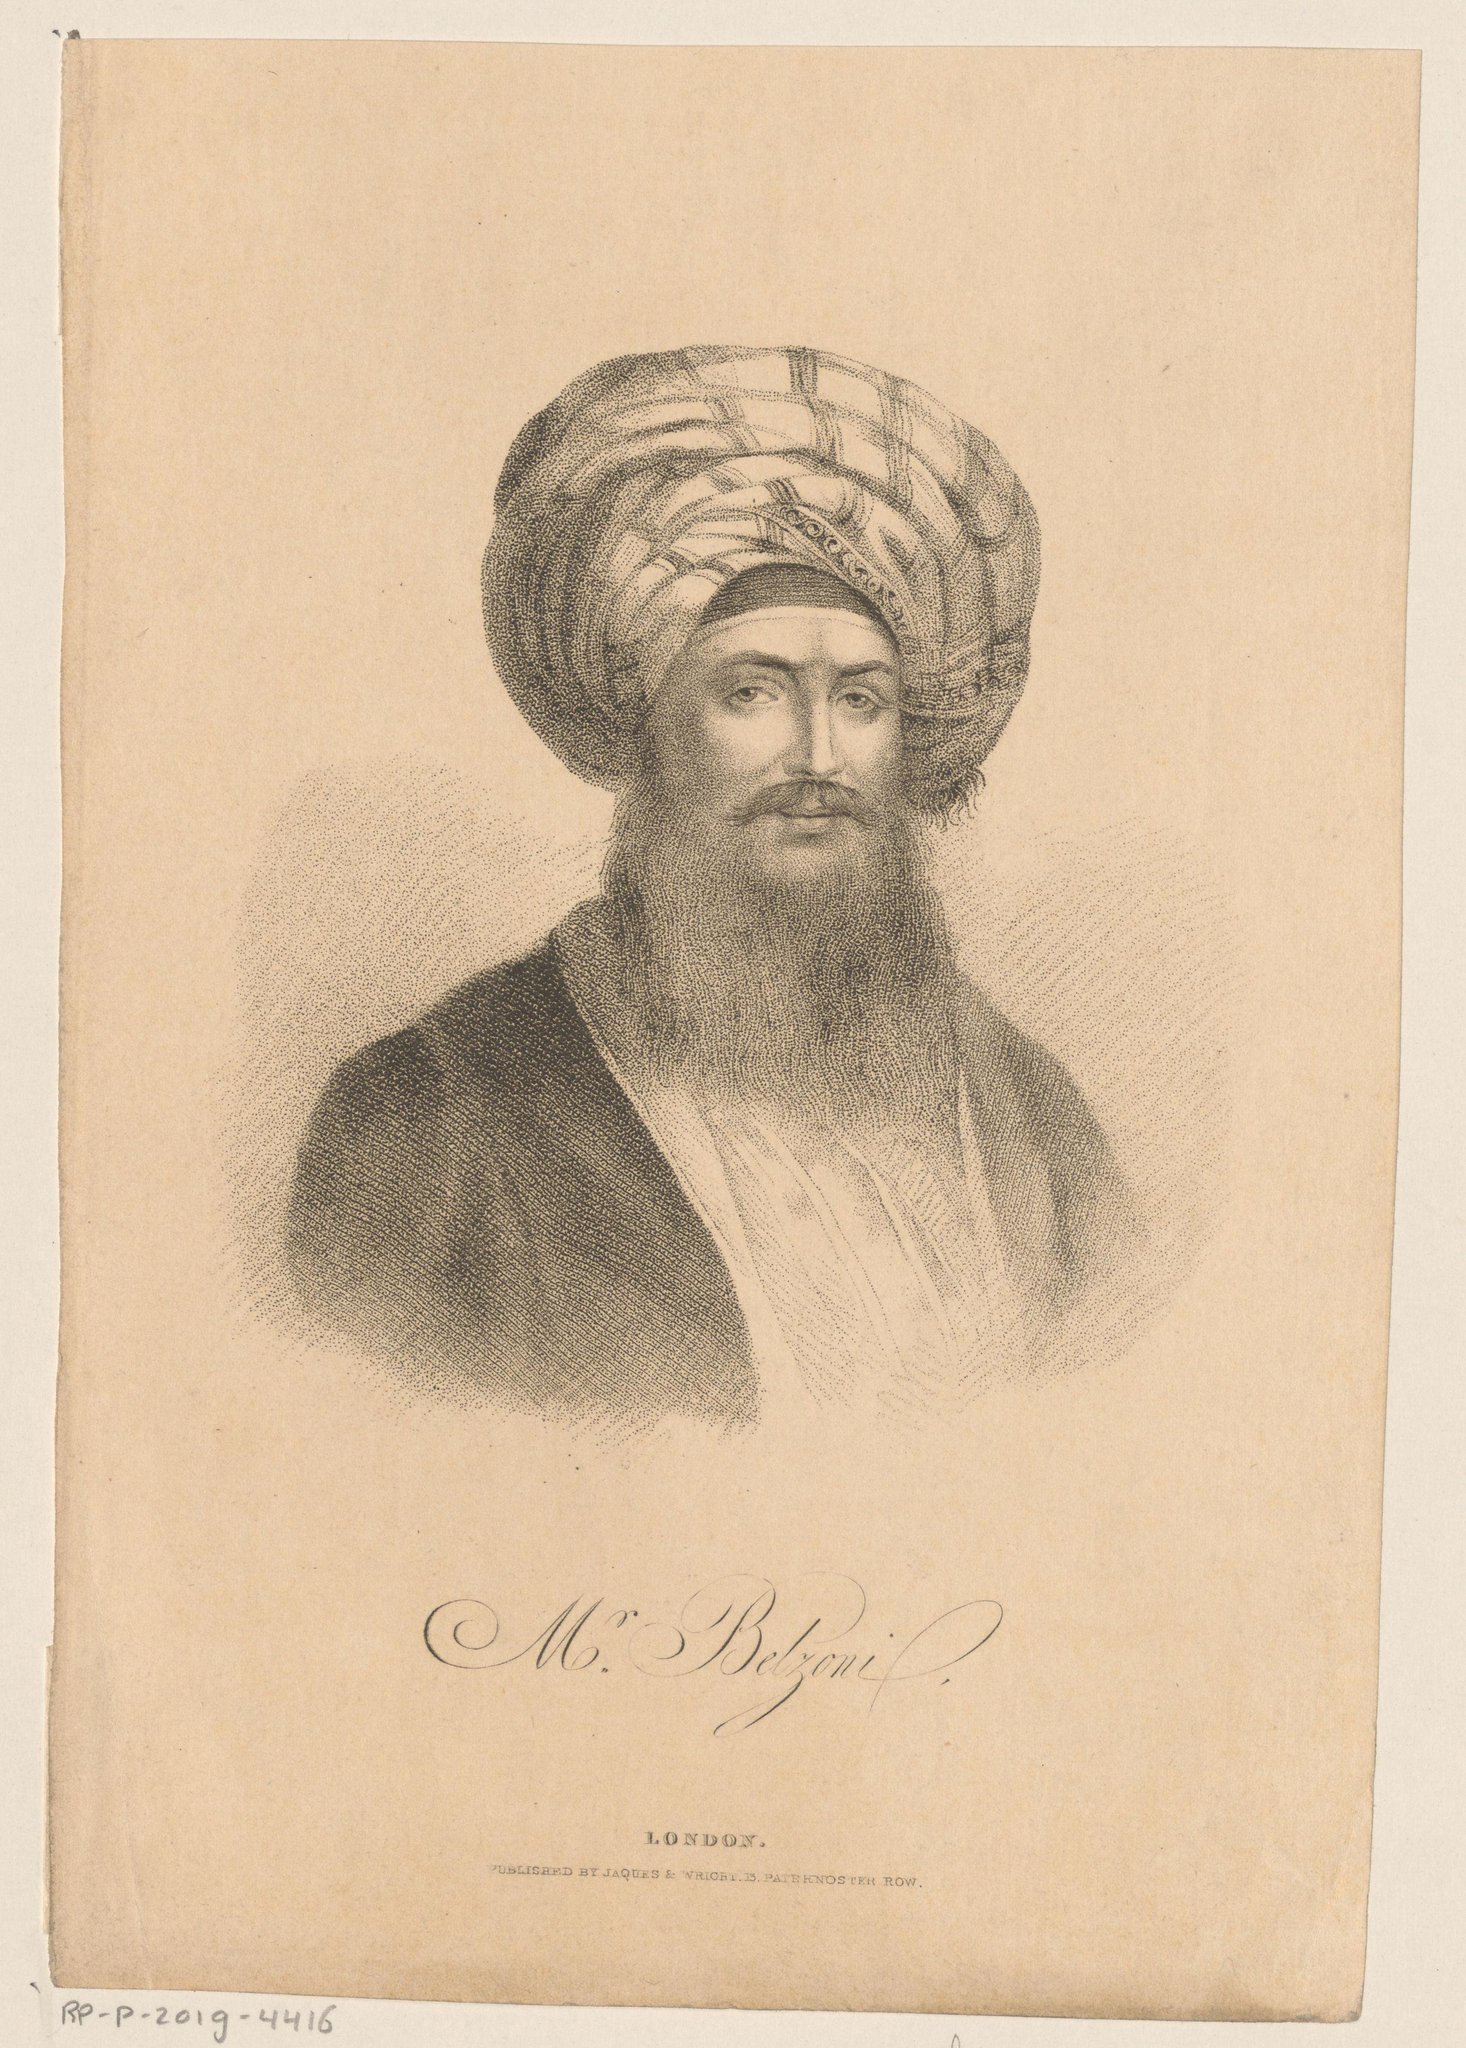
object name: print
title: Portret van Giovanni Battista Belzoni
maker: Anonymous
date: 1824-1828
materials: paper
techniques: etching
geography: london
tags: giovanni battista belzoni, historical persons, head-gear: turban